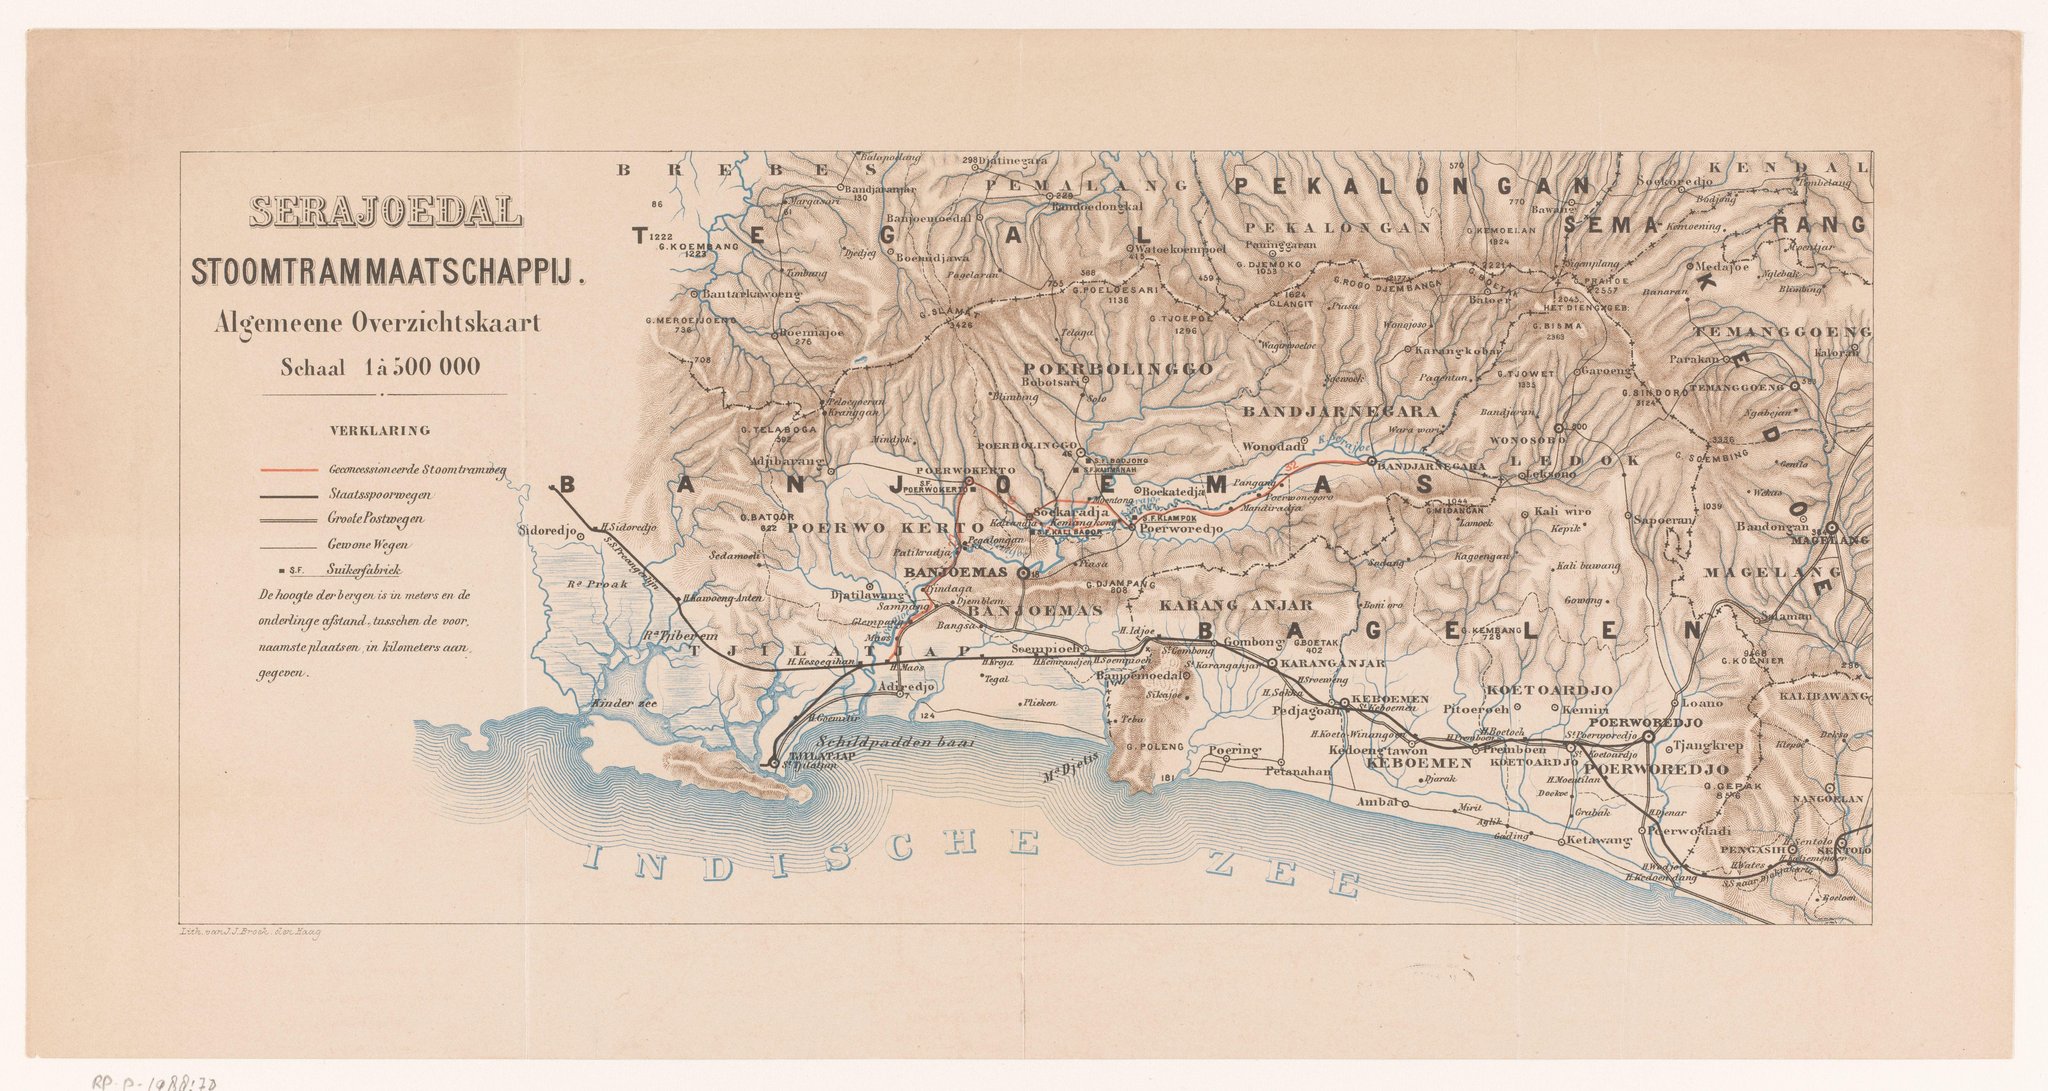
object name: print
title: Tracékaart van de Serajoedal Stoomtram Maatschappij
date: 1900-1920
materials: paper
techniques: lithograph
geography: the hague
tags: tramway, tram, java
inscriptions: collector's mark: Lugt 2228, collector's mark: Lugt 2760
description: De kaart geeft de spoorlijnen van de S.D.S.M. aan, in het gebied tussen Cilacap en Magelang, in Midden-Java.